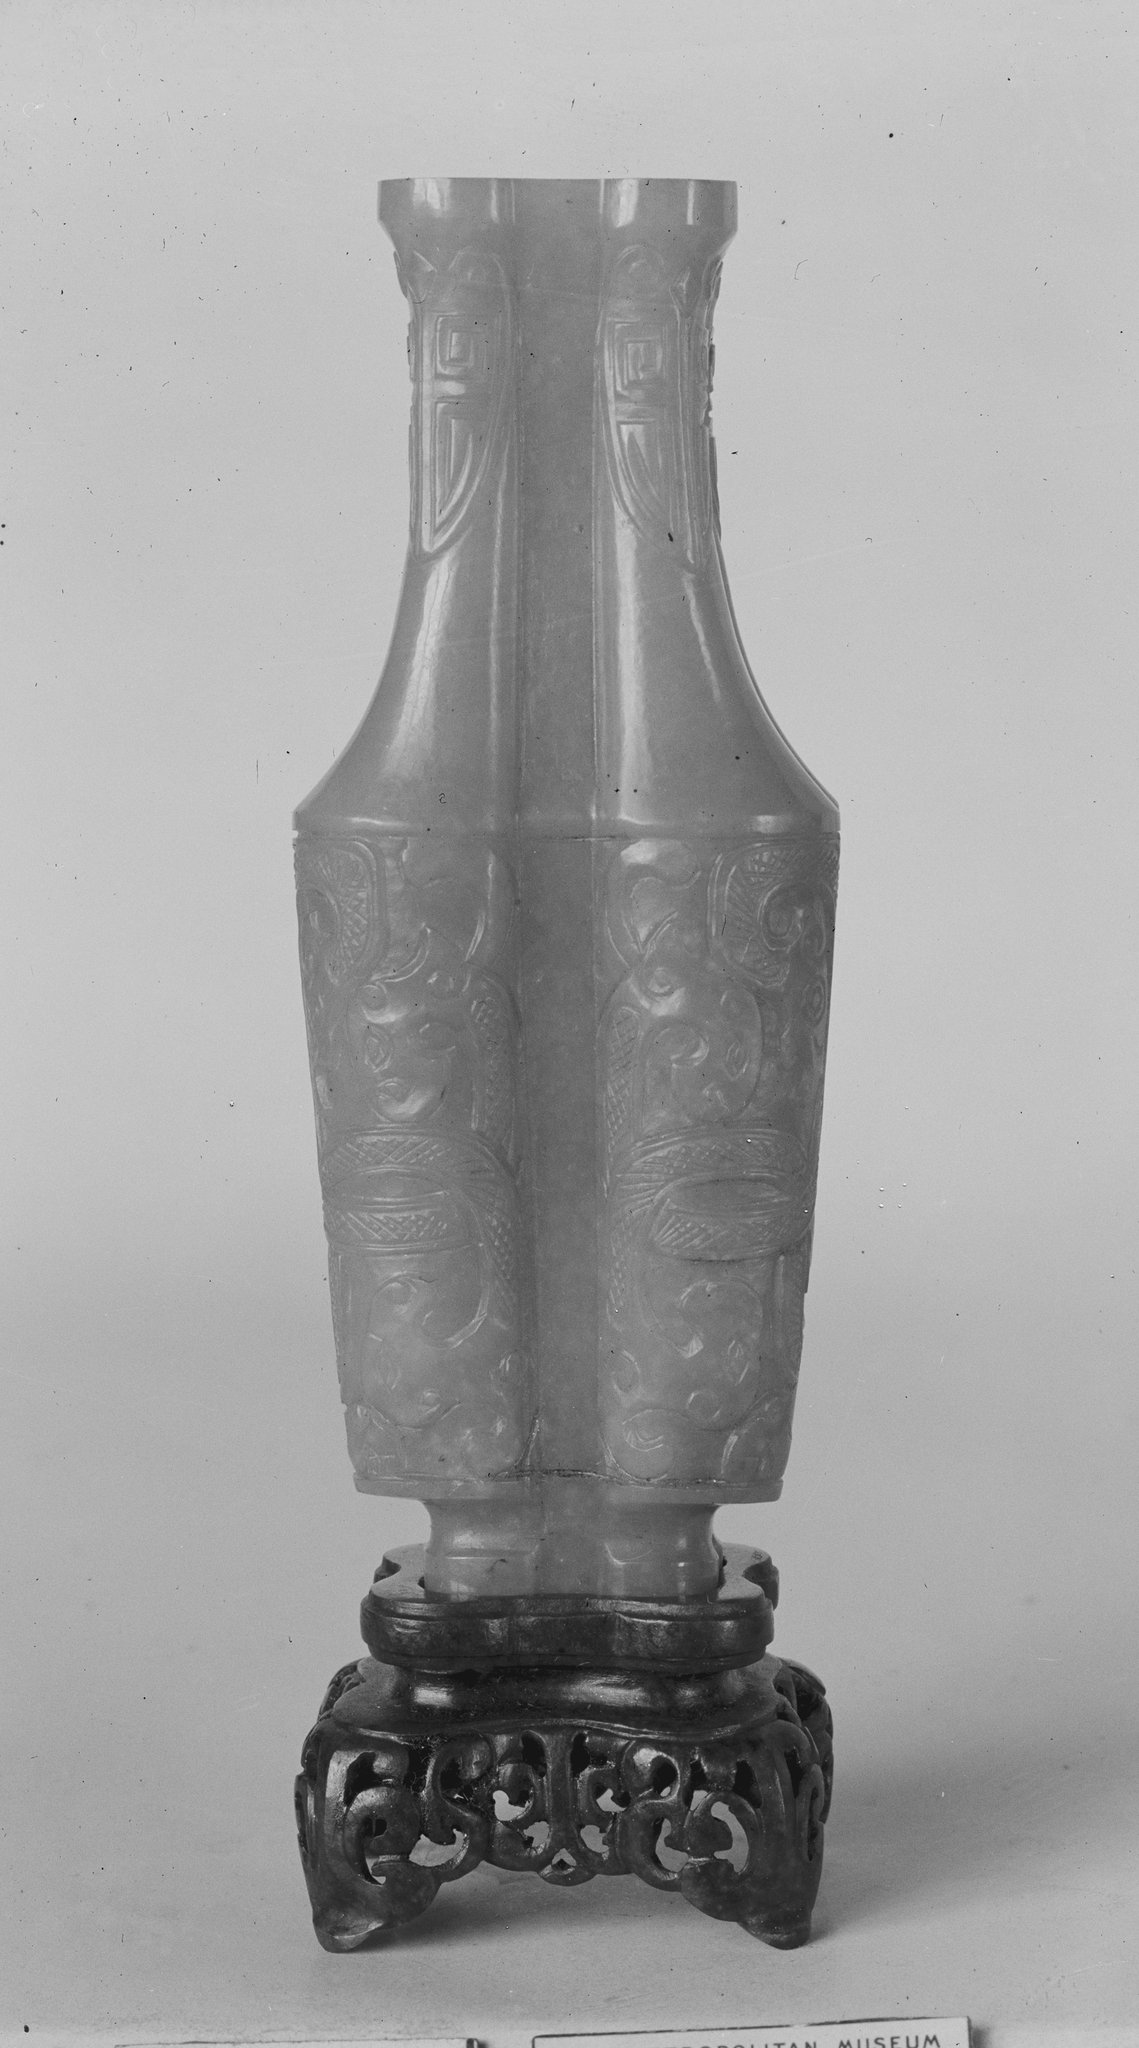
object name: incense utensil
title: Vase on Stand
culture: chinese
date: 1767-1833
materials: jade